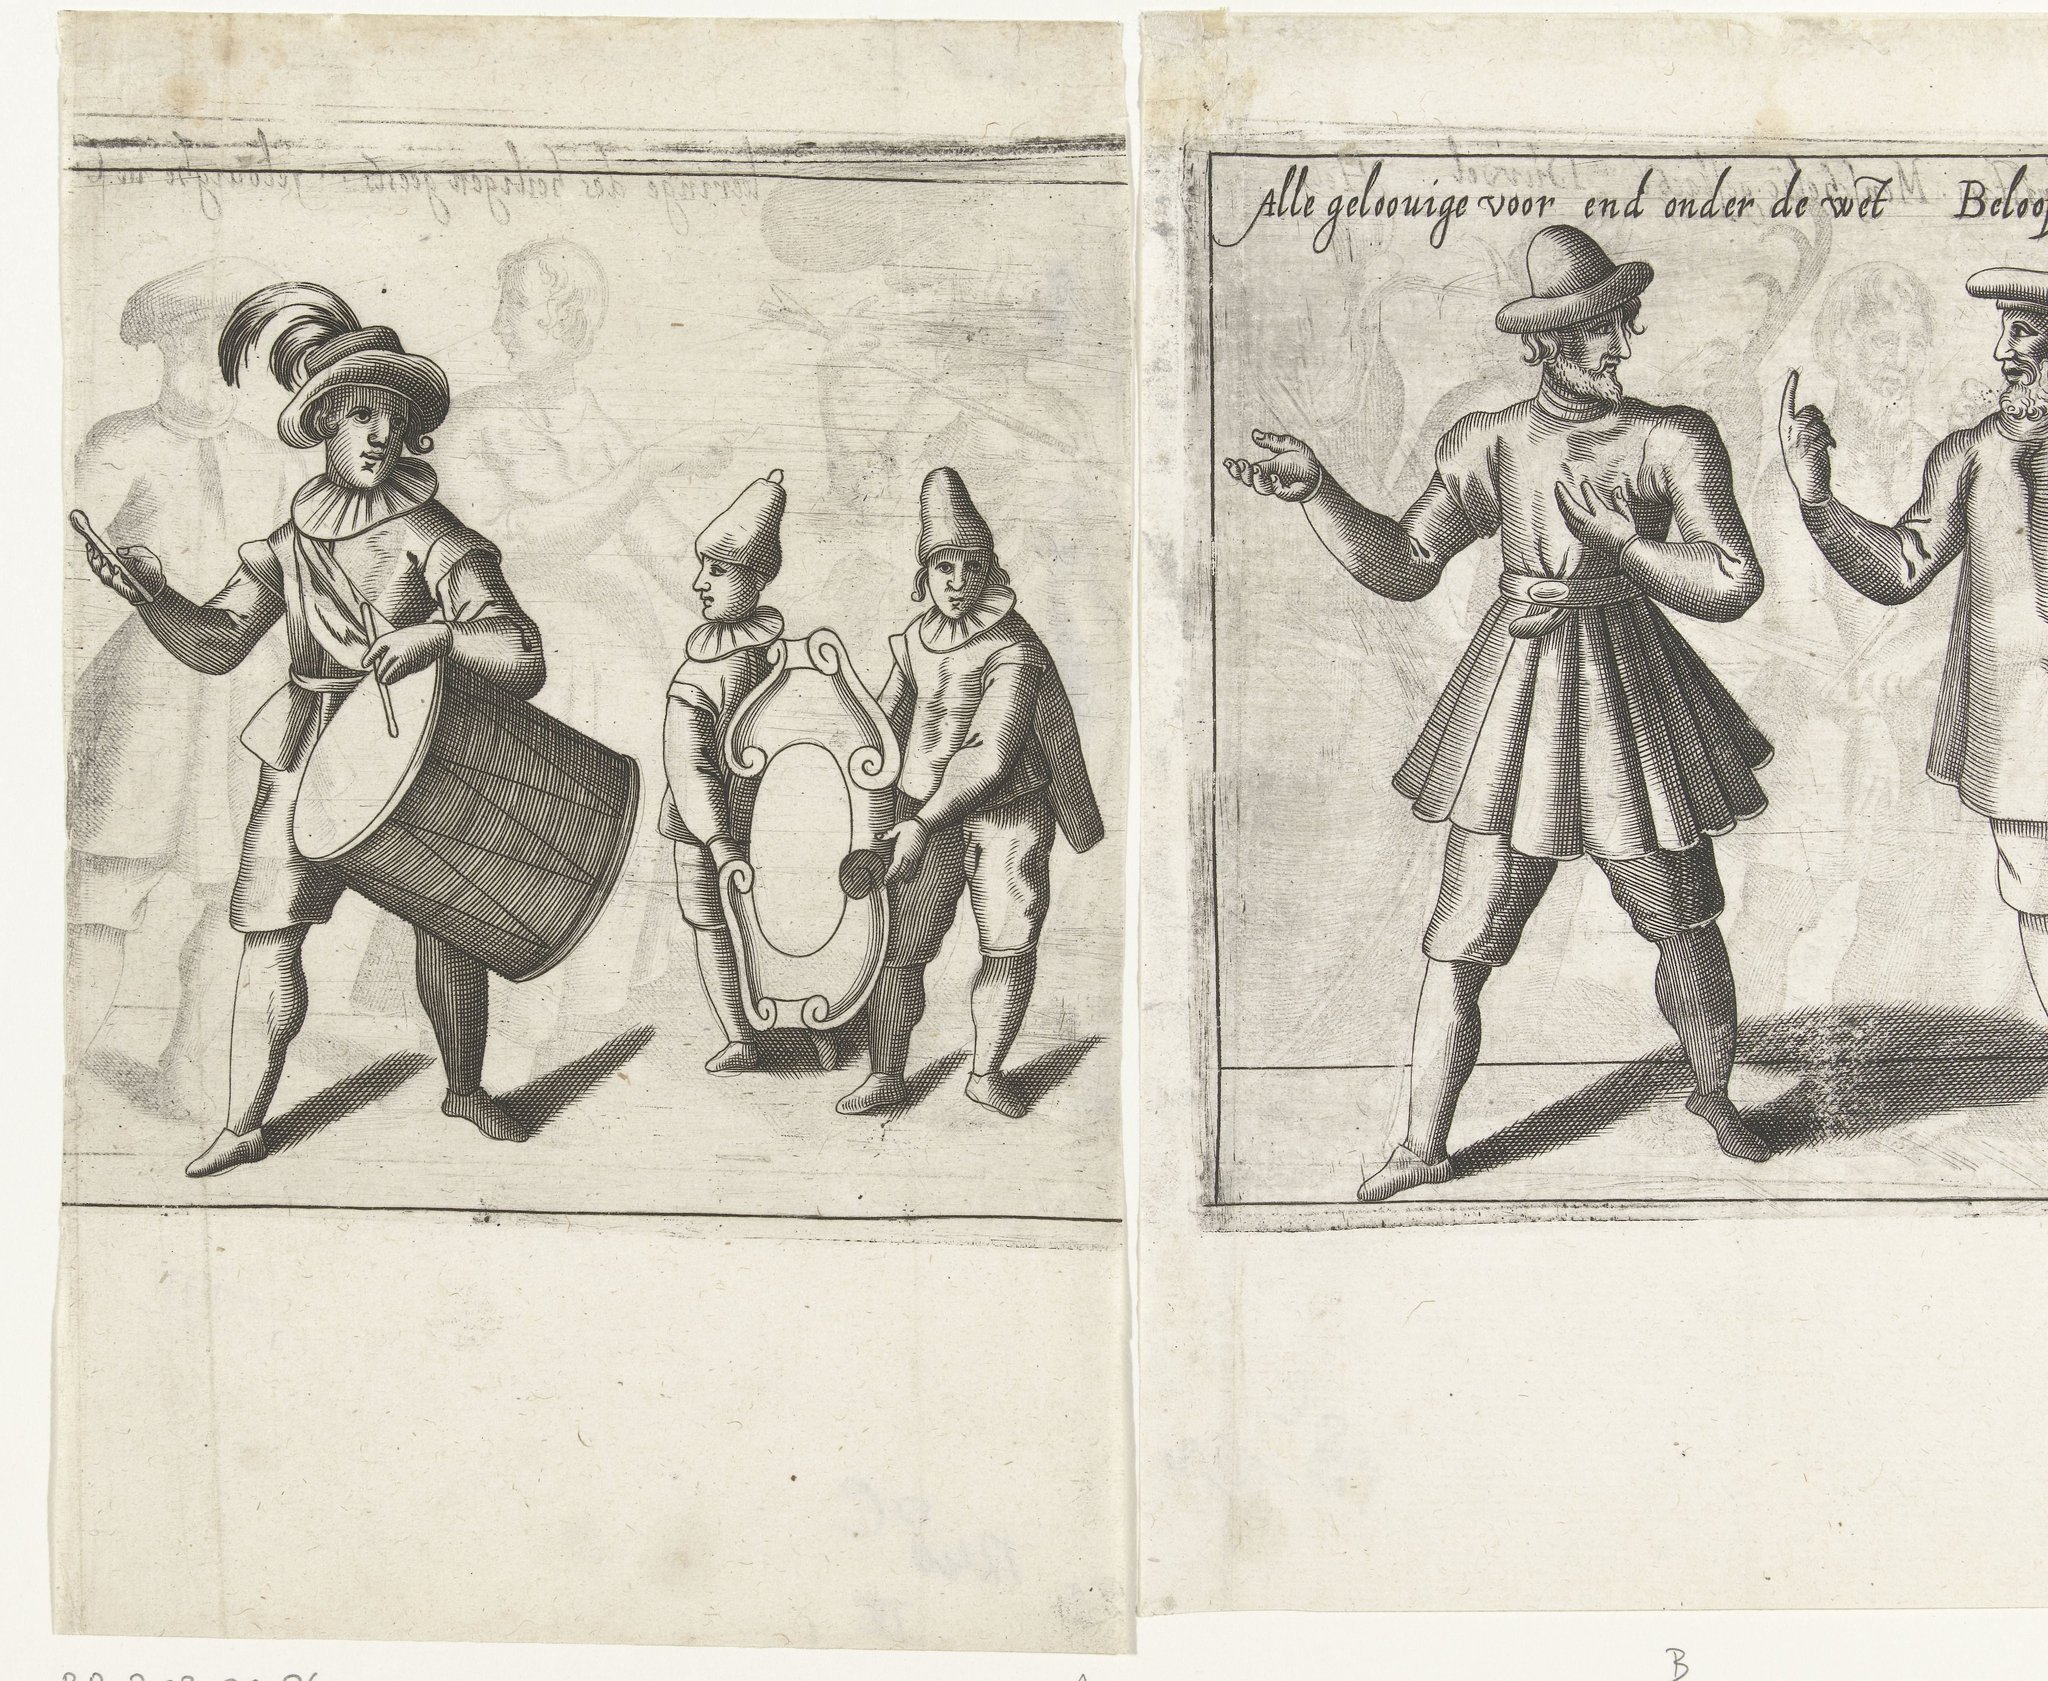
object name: print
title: De intrede van Aedwaertswoude verthoont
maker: Anonymous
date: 1607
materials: paper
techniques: engraving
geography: northern netherlands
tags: chamber of rhetoric (dutch: 'rederijkerskamer'), festivities (+ parade, pageant, cavalcade ~ festive activities), haarlem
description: Gebruikt als illustratie in: Const-thoonende ivweel, by de loflijcke stadt Haerlem, ten versoecke van Trou moet blijcken, in't licht gebracht. : Waer inne duydelick verclaert ende verthoont wordt alles wat den mensche mach wecken om den armen te troosten, ende zijnen naesten by te staen. : In twaelf spelen van sinne ... in redenrijck naar de volgende voorgegevene caerte van 't speel-korenken, Zacharias Heyns, Zwolle 1607. Los fragment, bedoeld om samen met de andere delen tot een fries gemonteerd te worden.